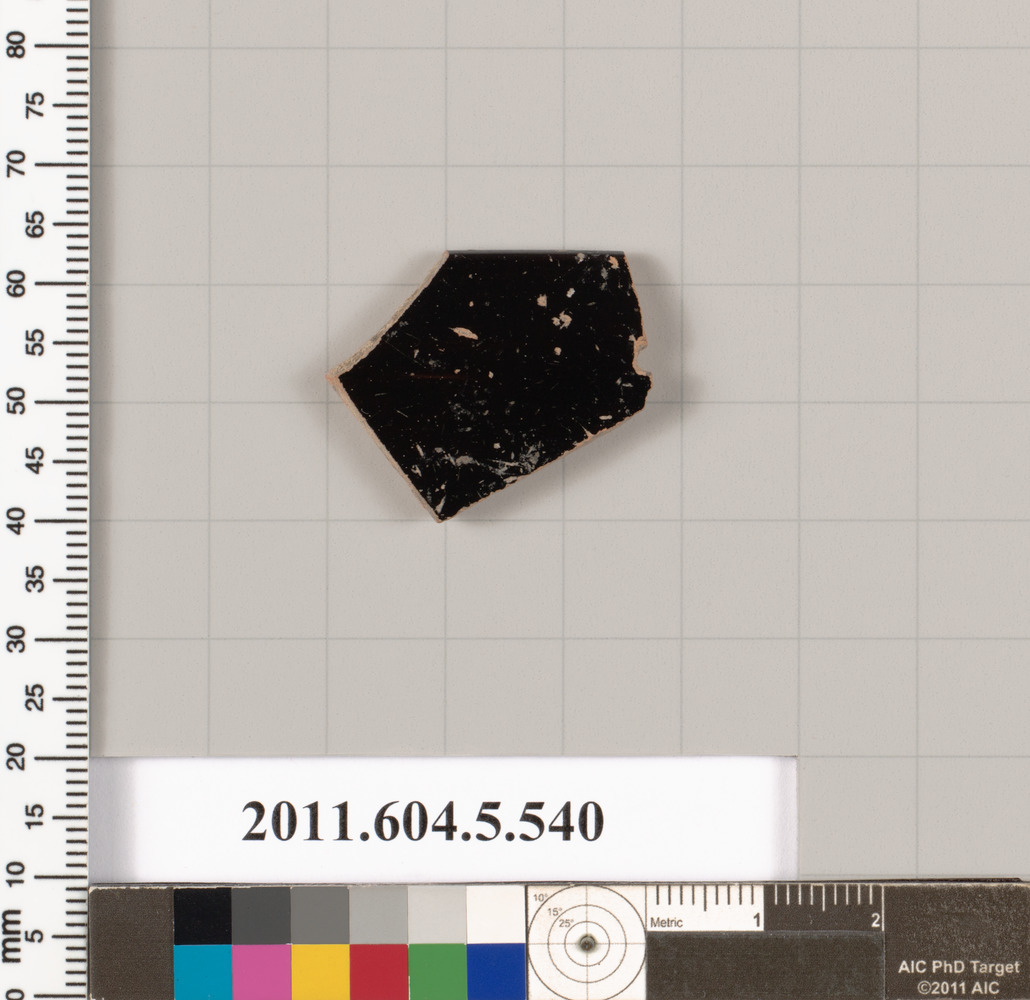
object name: kylix fragment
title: Terracotta fragment of a kylix (drinking cup)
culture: greek, attic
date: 600-401 BCE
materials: terracotta